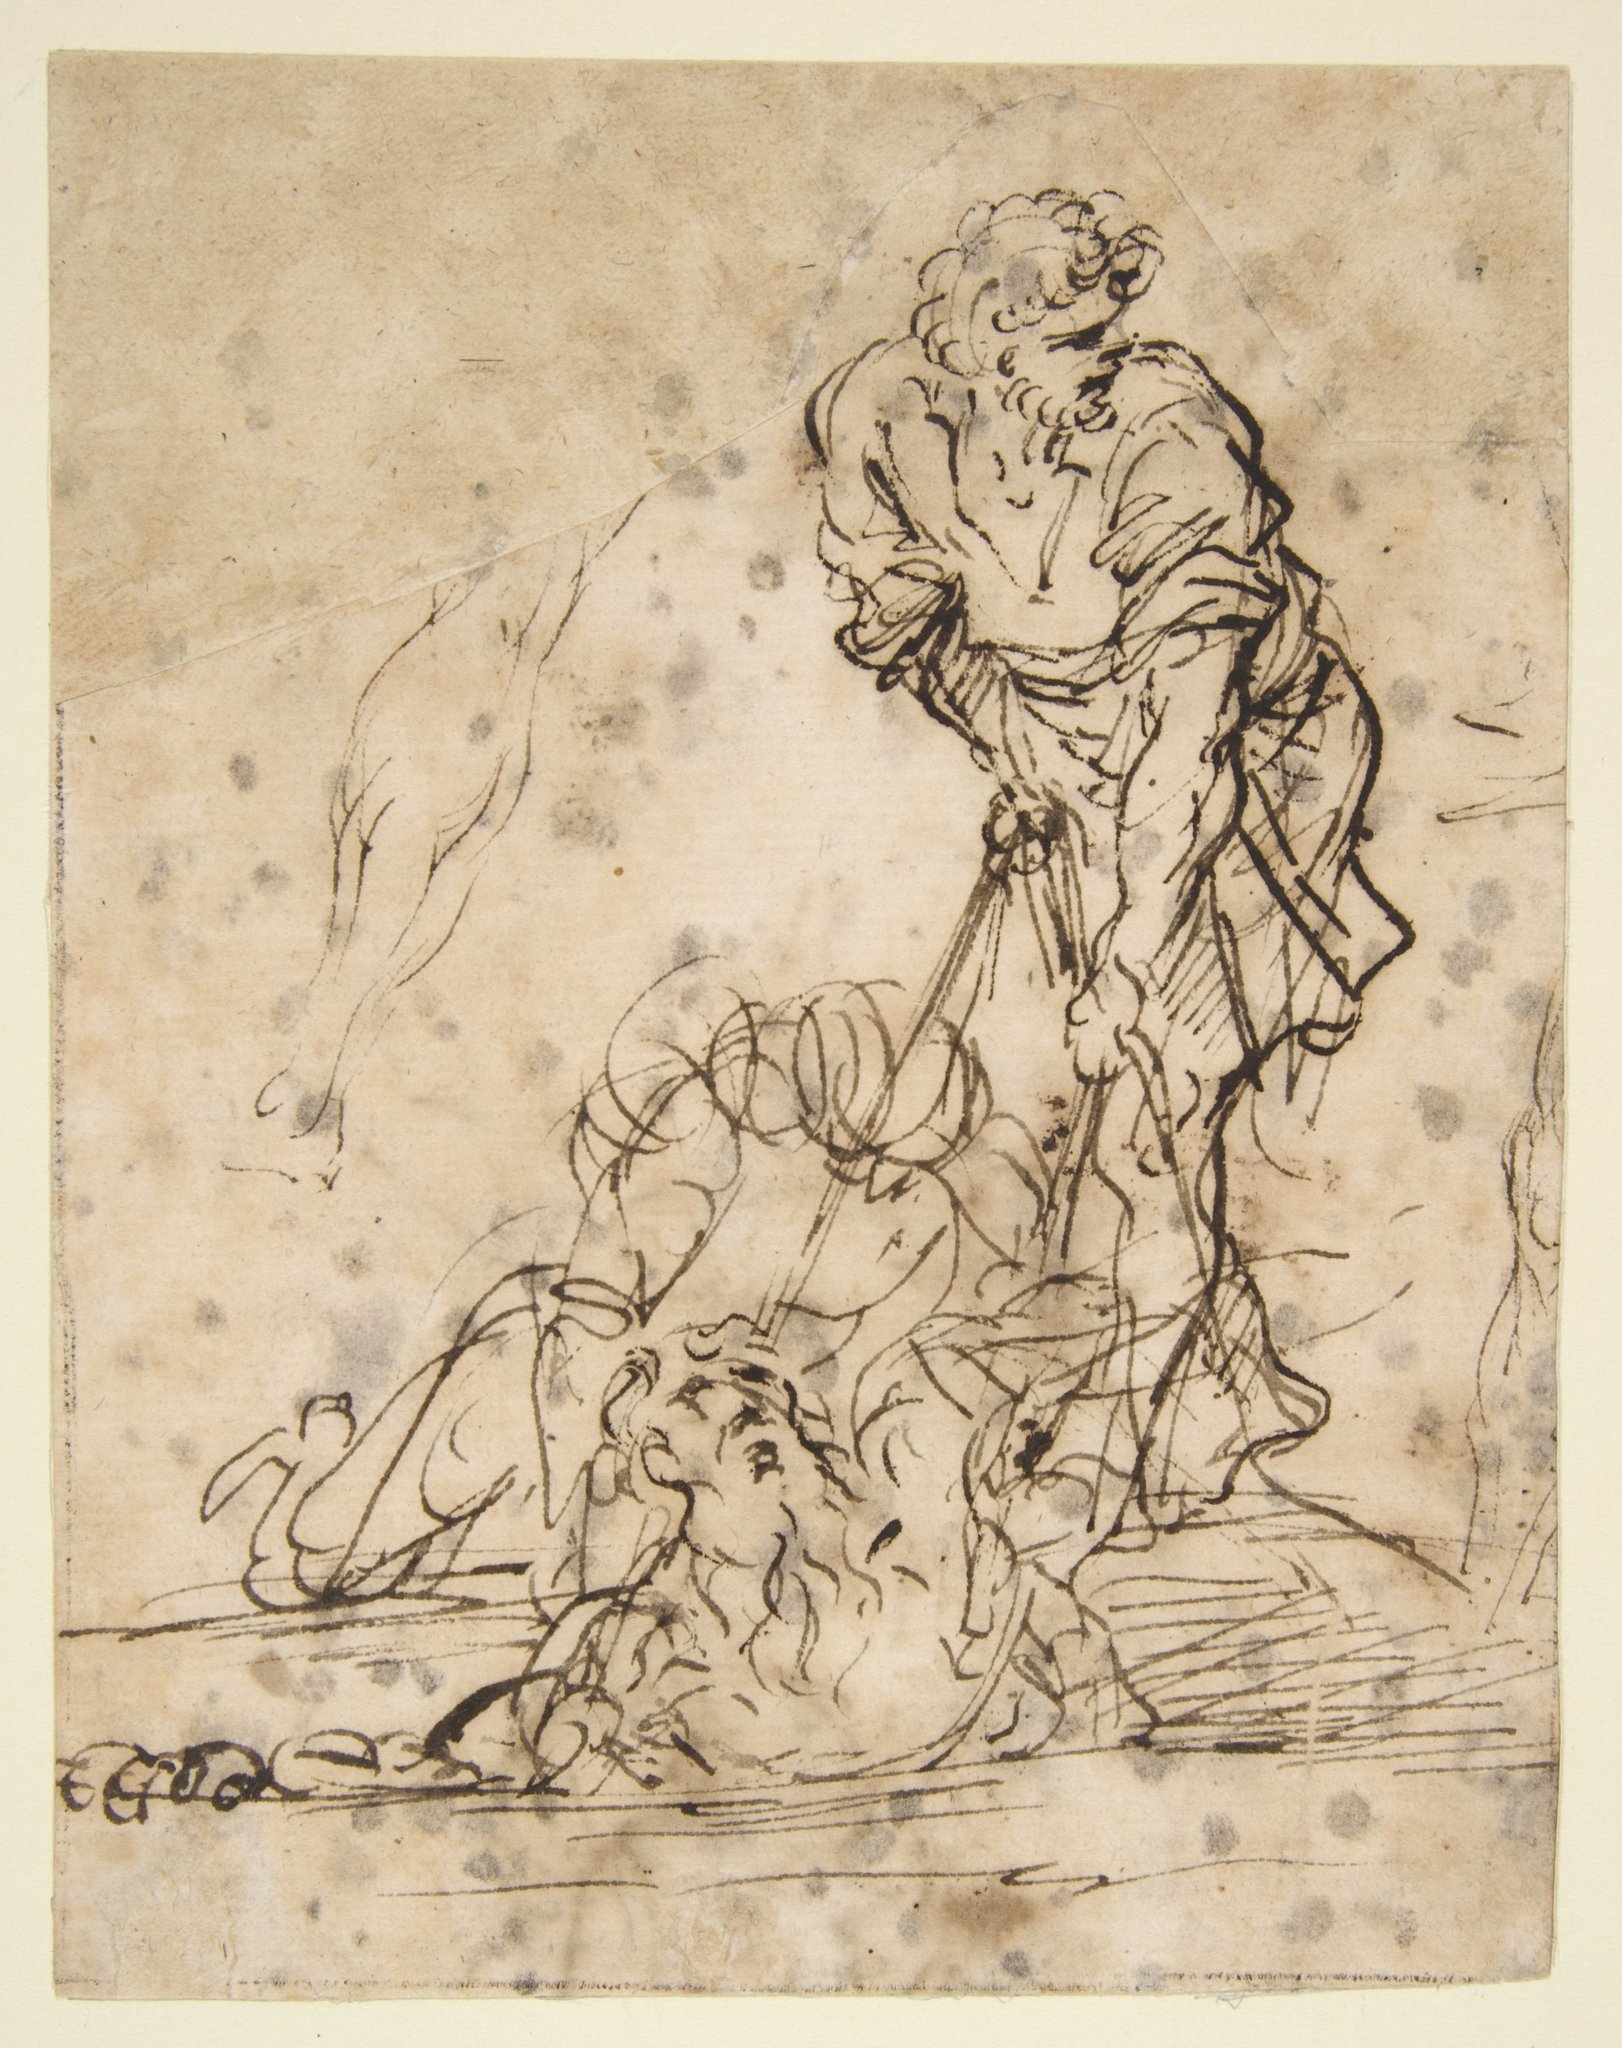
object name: drawing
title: Studies for a Figure Lifted from a Grave or Pit by Cords (recto); Further Study of the Same Figure (verso)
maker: salvator rosa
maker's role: artist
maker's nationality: italian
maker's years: 1615-1673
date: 1615-1673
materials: ink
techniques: pen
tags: men